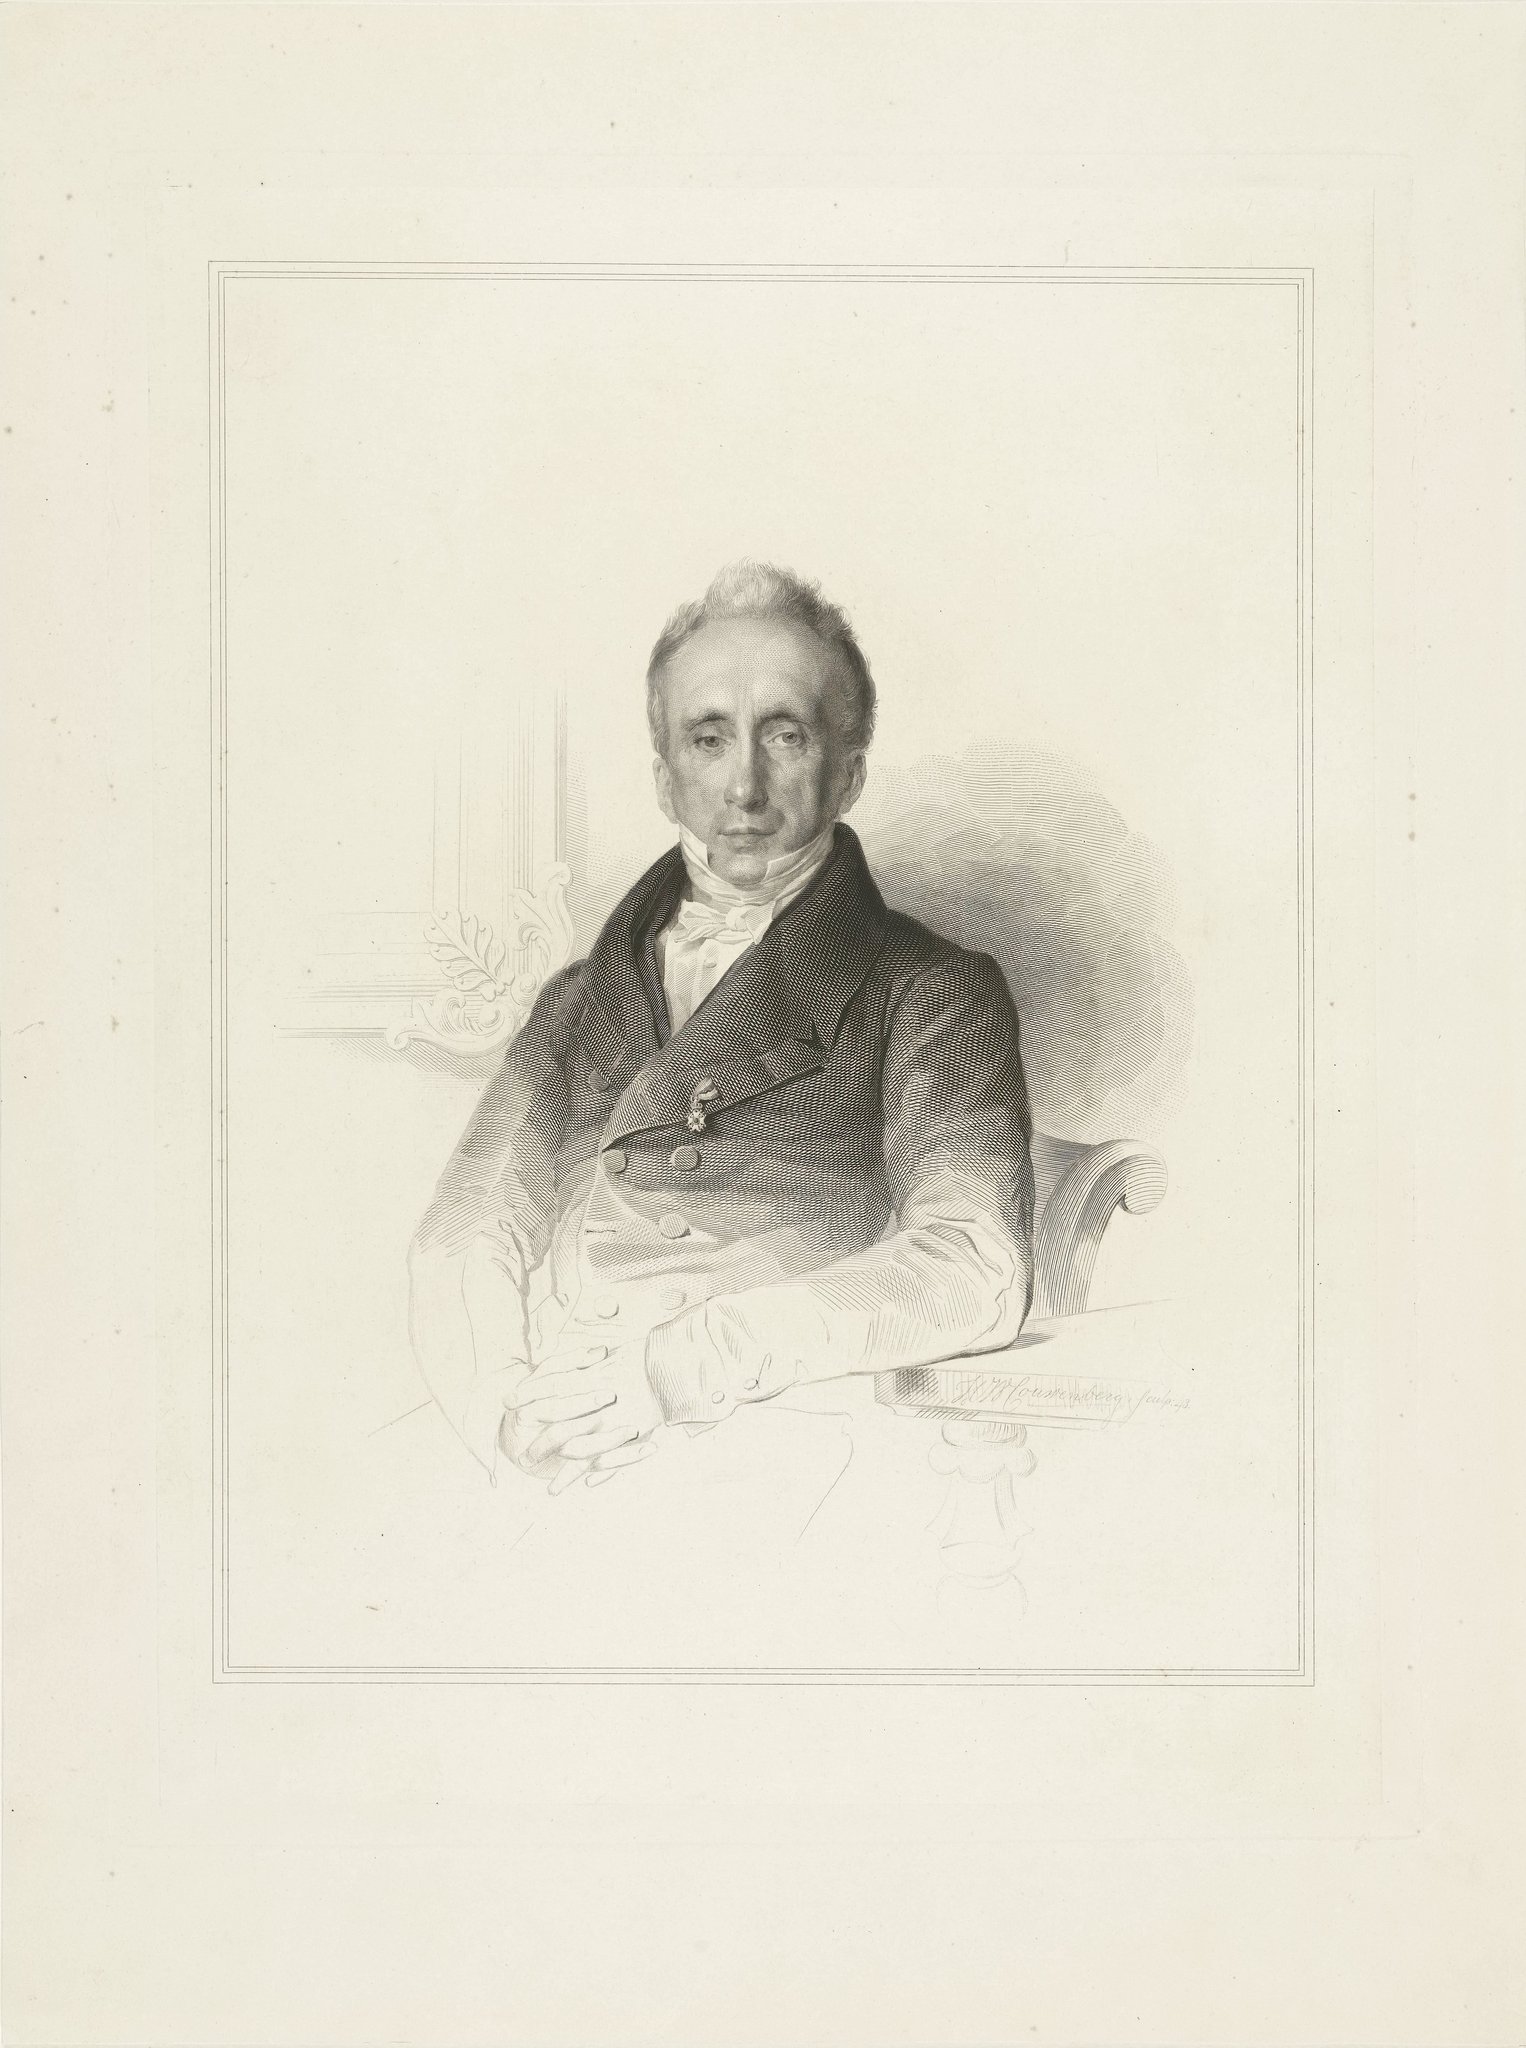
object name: print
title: Portret van Jacob Mendes de Leon, lid van de Amsterdamse gemeenteraad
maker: henricus wilhelmus couwenberg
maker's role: draughtsman, print maker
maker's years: 1814-1845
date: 1843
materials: paper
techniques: engraving, roulette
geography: amsterdam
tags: jacob mendes de leon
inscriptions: collector's mark: Lugt 2228